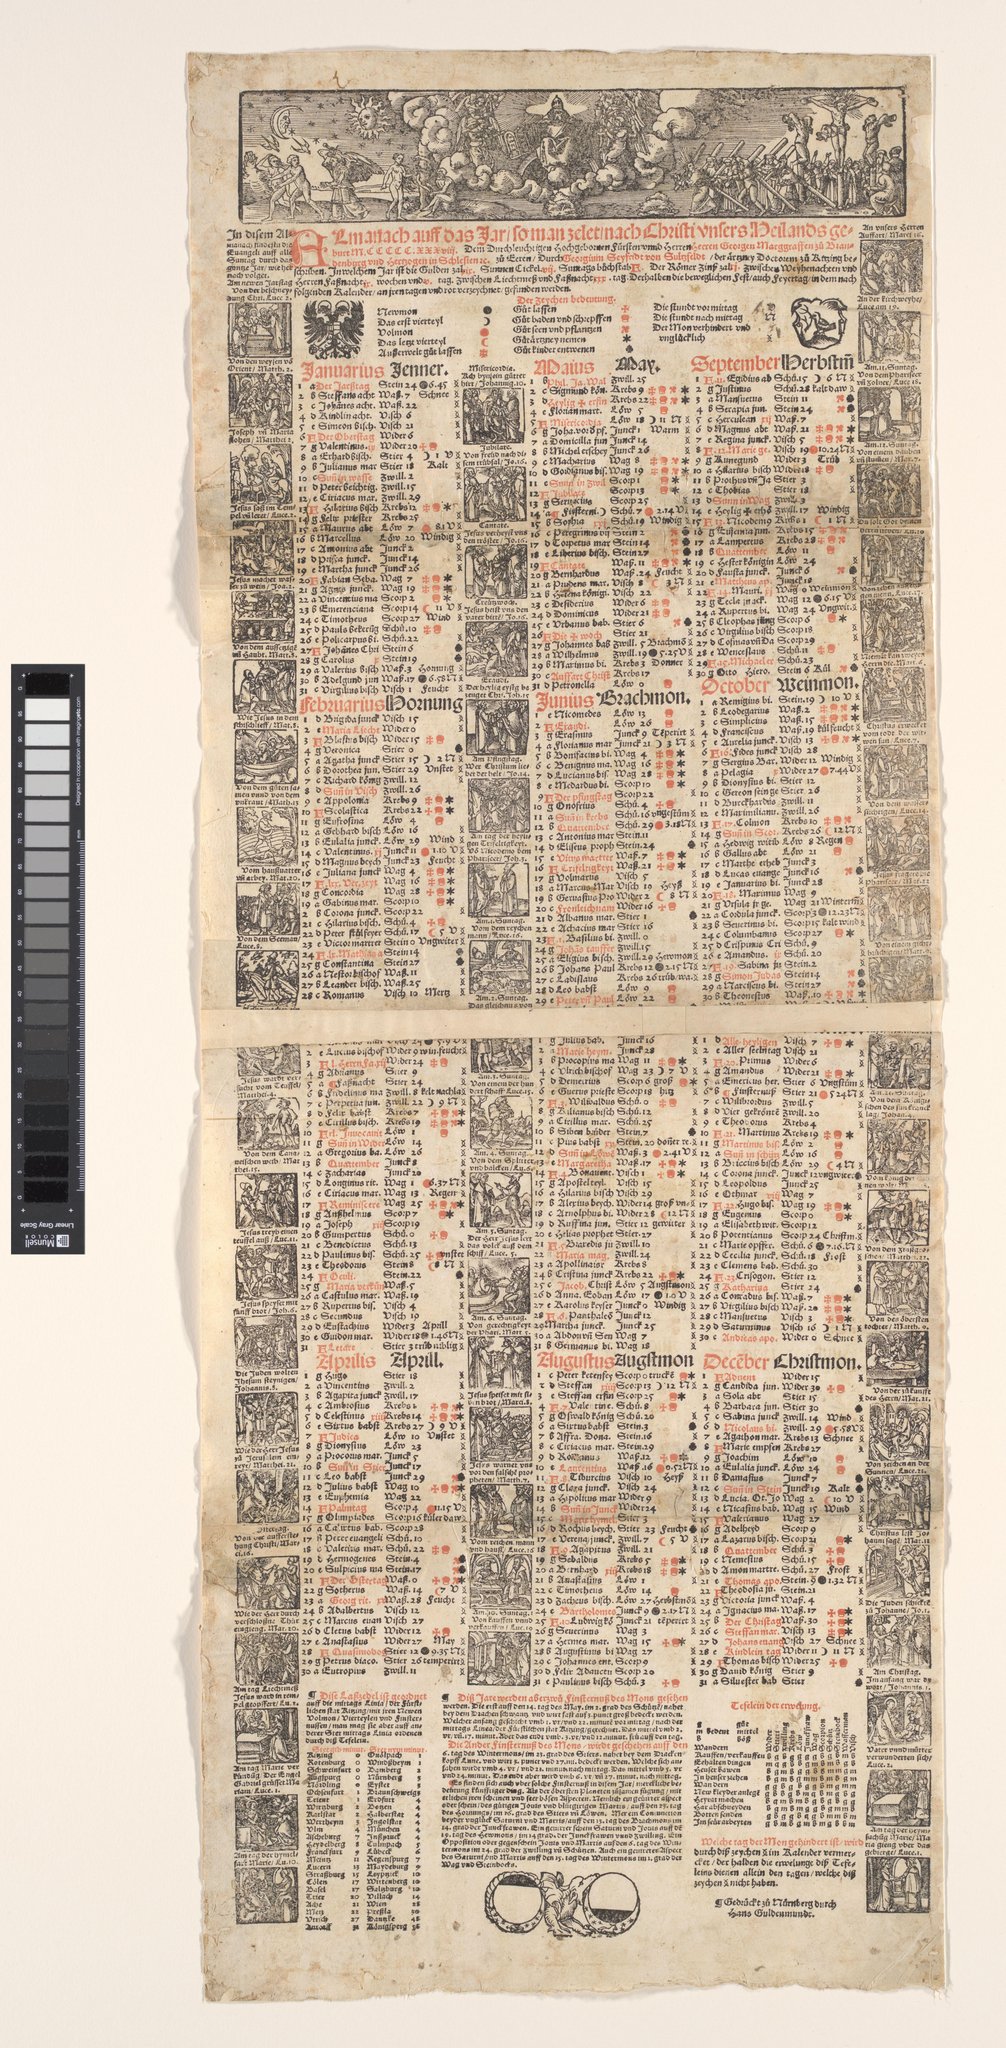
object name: print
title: Wandalmanak voor het jaar 1538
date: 1538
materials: paper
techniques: hand coloring, letterpress printing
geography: nuremberg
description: Wandalmanak voor het jaar 1538 uit Neurenberg.